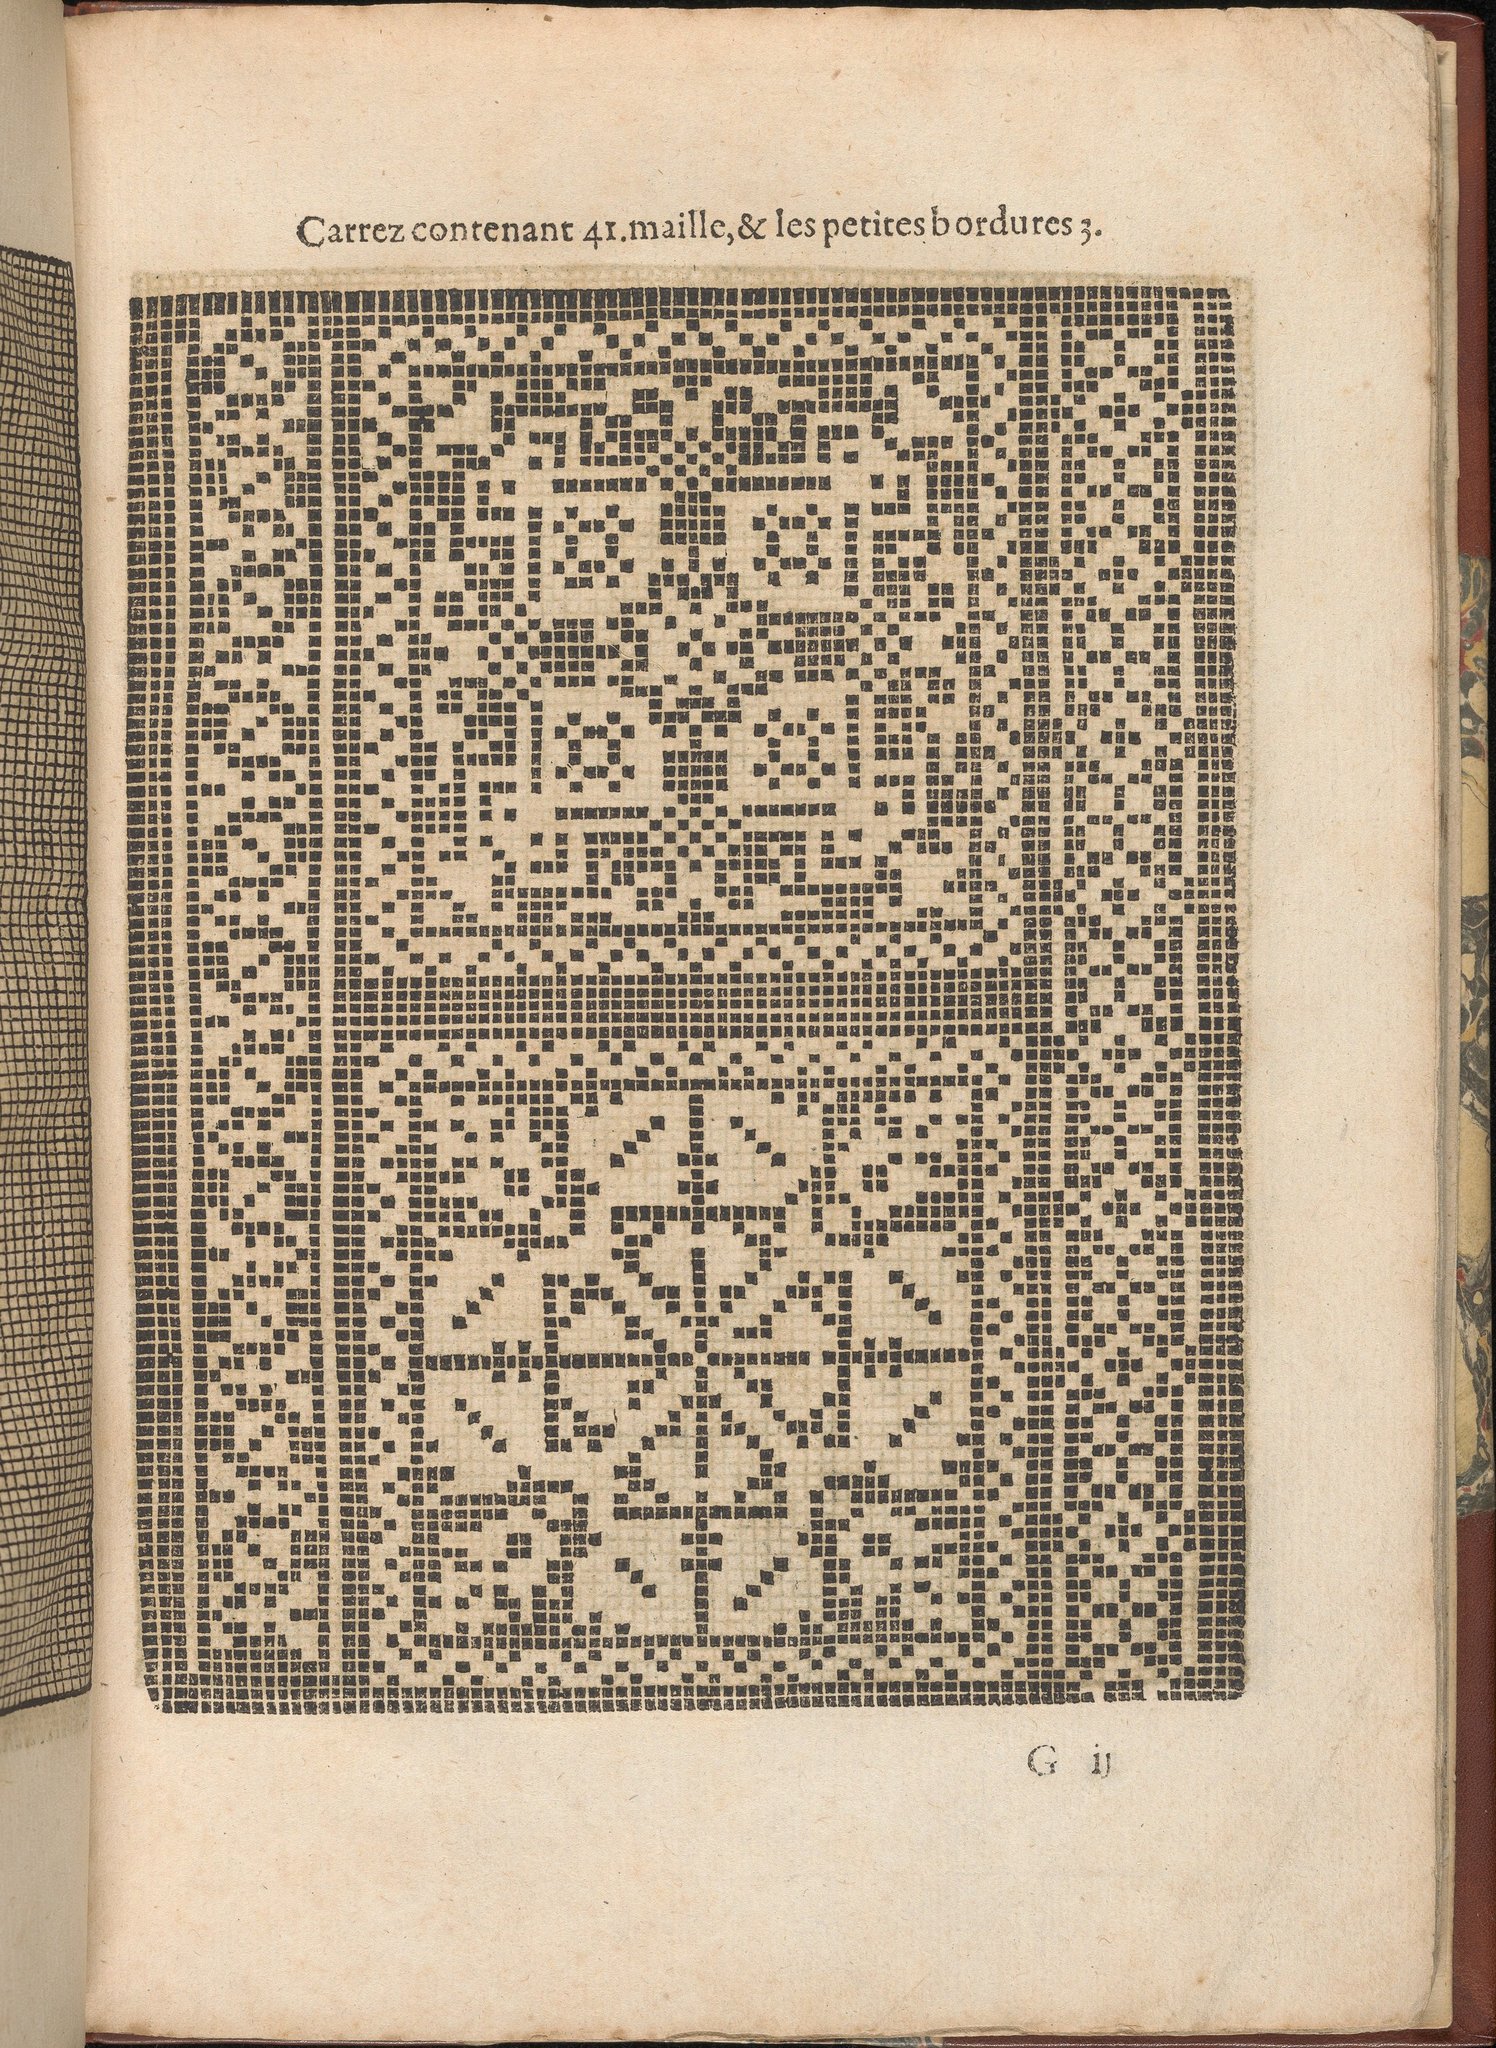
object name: book print ornament architecture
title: Les Secondes Oeuvres, et Subtiles Inventions De Lingerie du Seigneur Federic de Vinciolo Venitien, page 26 (recto)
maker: federico de vinciolo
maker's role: designer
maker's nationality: italian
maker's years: 1582-1599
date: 1603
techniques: woodcut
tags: ornament